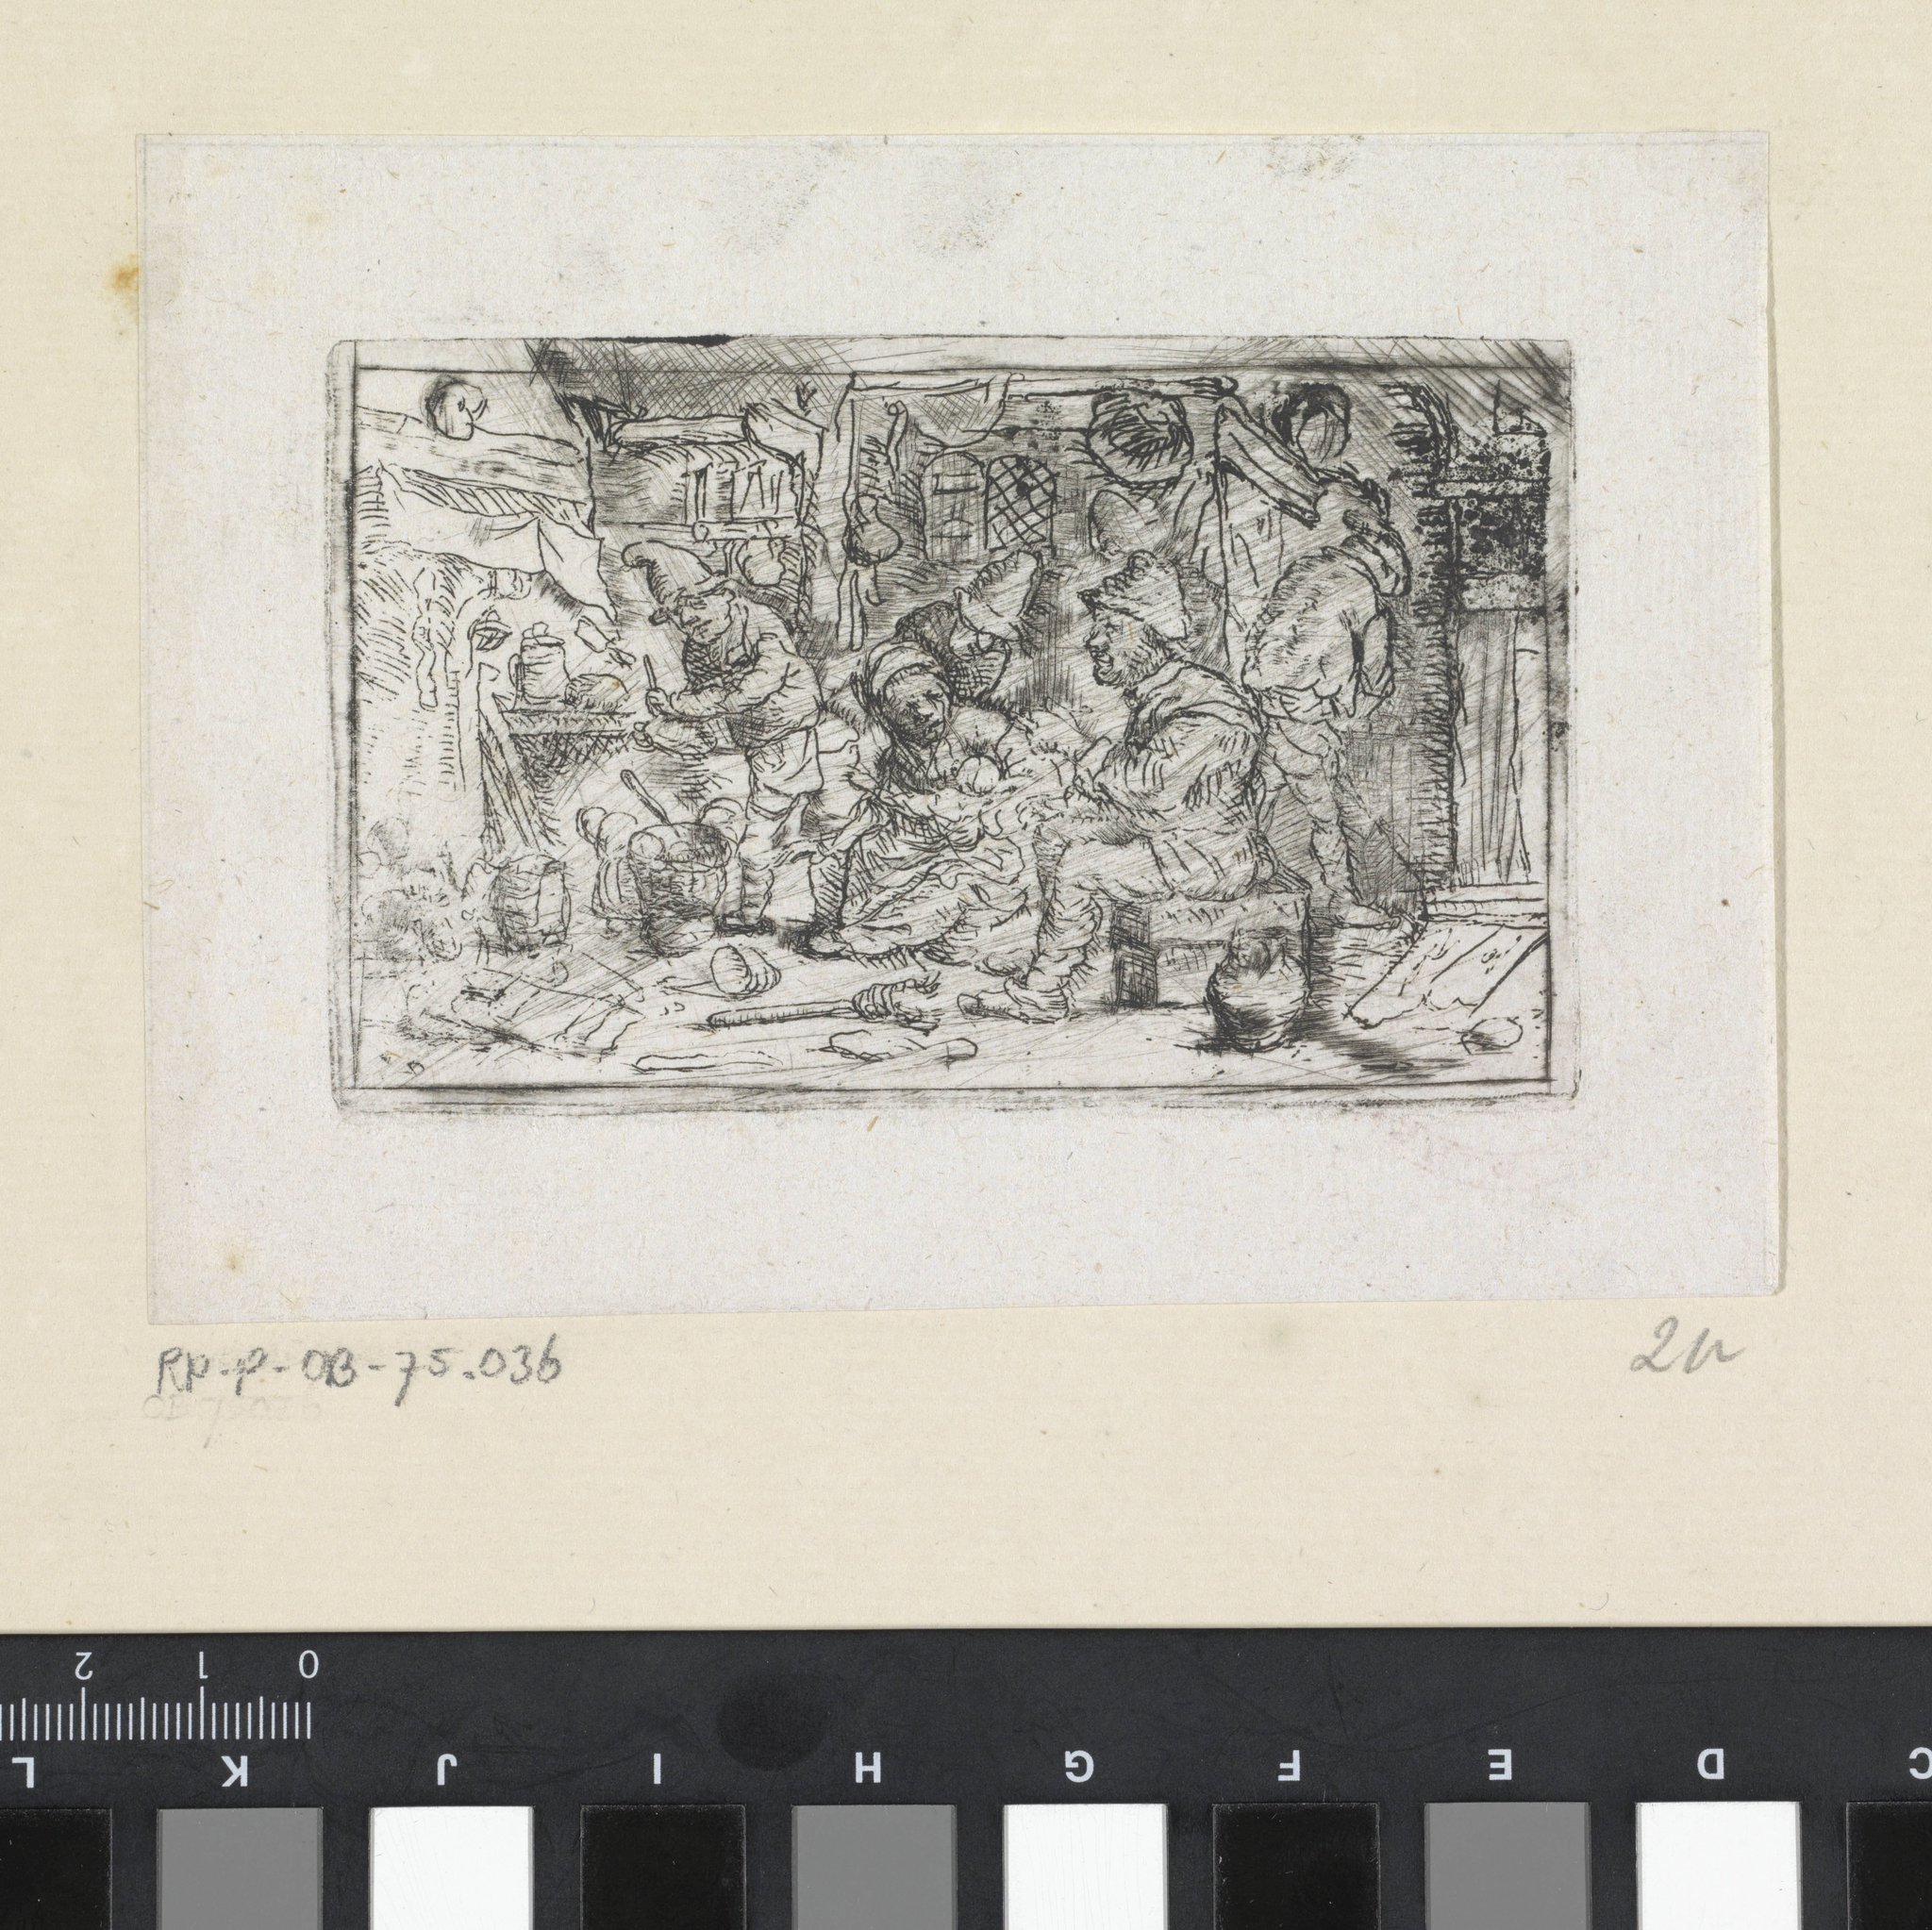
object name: print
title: Boereninterieur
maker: Anonymous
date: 1600-1700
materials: paper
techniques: drypoint, etching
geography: netherlands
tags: interior of the house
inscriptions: collector's mark: Lugt 240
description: Boereninterieur met een man bij de haard, een zittende vrouw met baby op schoot, een zittende man en rechts in de hoek een urinerende man.